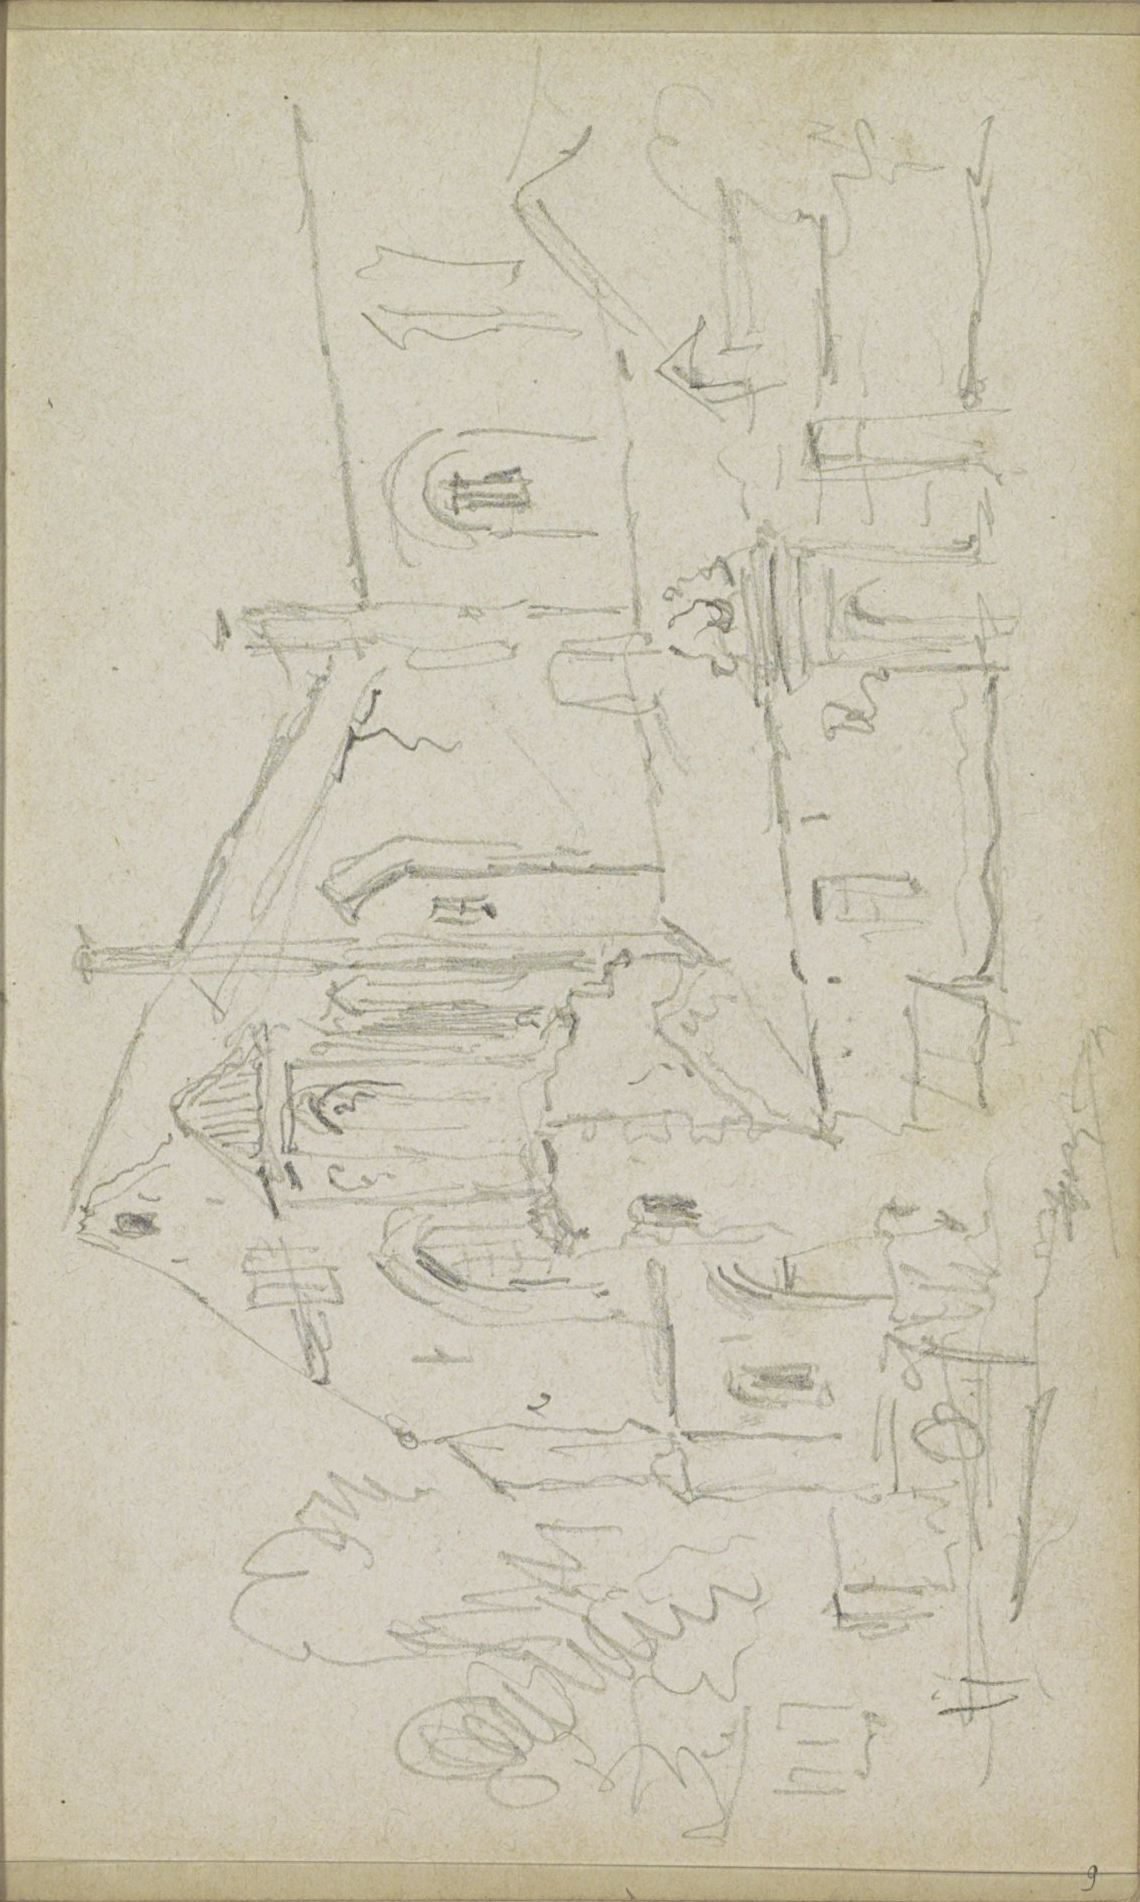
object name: sketchbook leaf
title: Gezicht op een gebouw met een poort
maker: adrianus eversen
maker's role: draughtsman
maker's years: 1818-1897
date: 1828-1897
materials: paper, pencil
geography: netherlands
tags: church (exterior), street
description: Gezicht op een gebouw, mogelijk een kerk, met rechts een poort. Links bomen. Blad 9 recto uit een schetsboek met 69 bladen vervaardigd in de omgeving van Delft, Rotterdam, Oudewater en Harlingen.